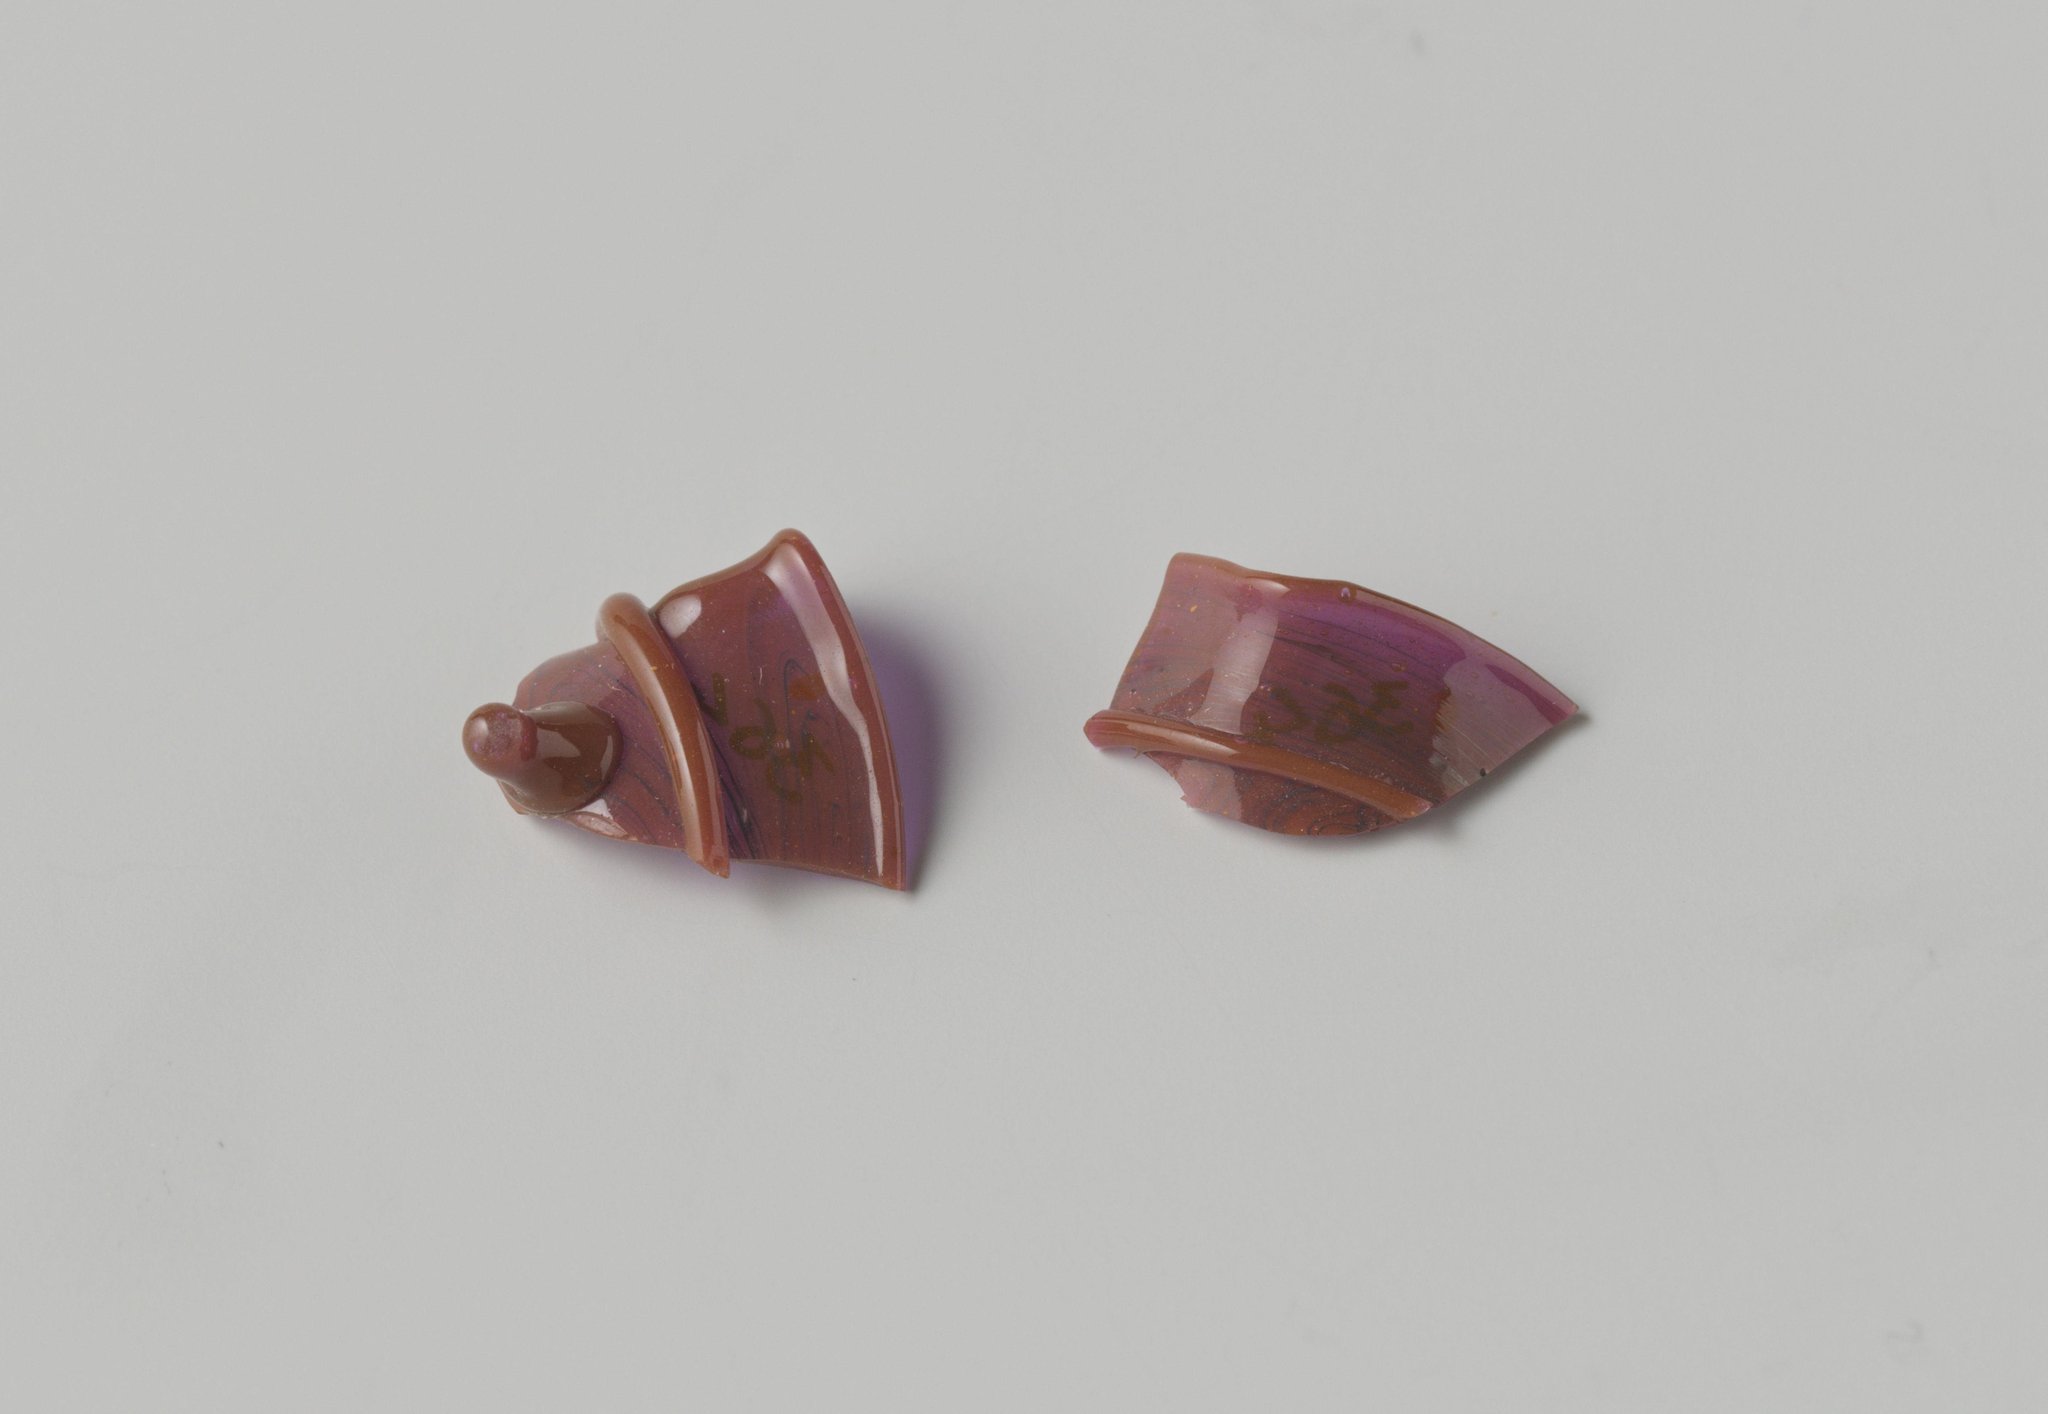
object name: miniature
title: Scherf van bruinpaars glas; rest van een vuurtest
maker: Anonymous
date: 1675-1710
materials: glass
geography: amsterdam